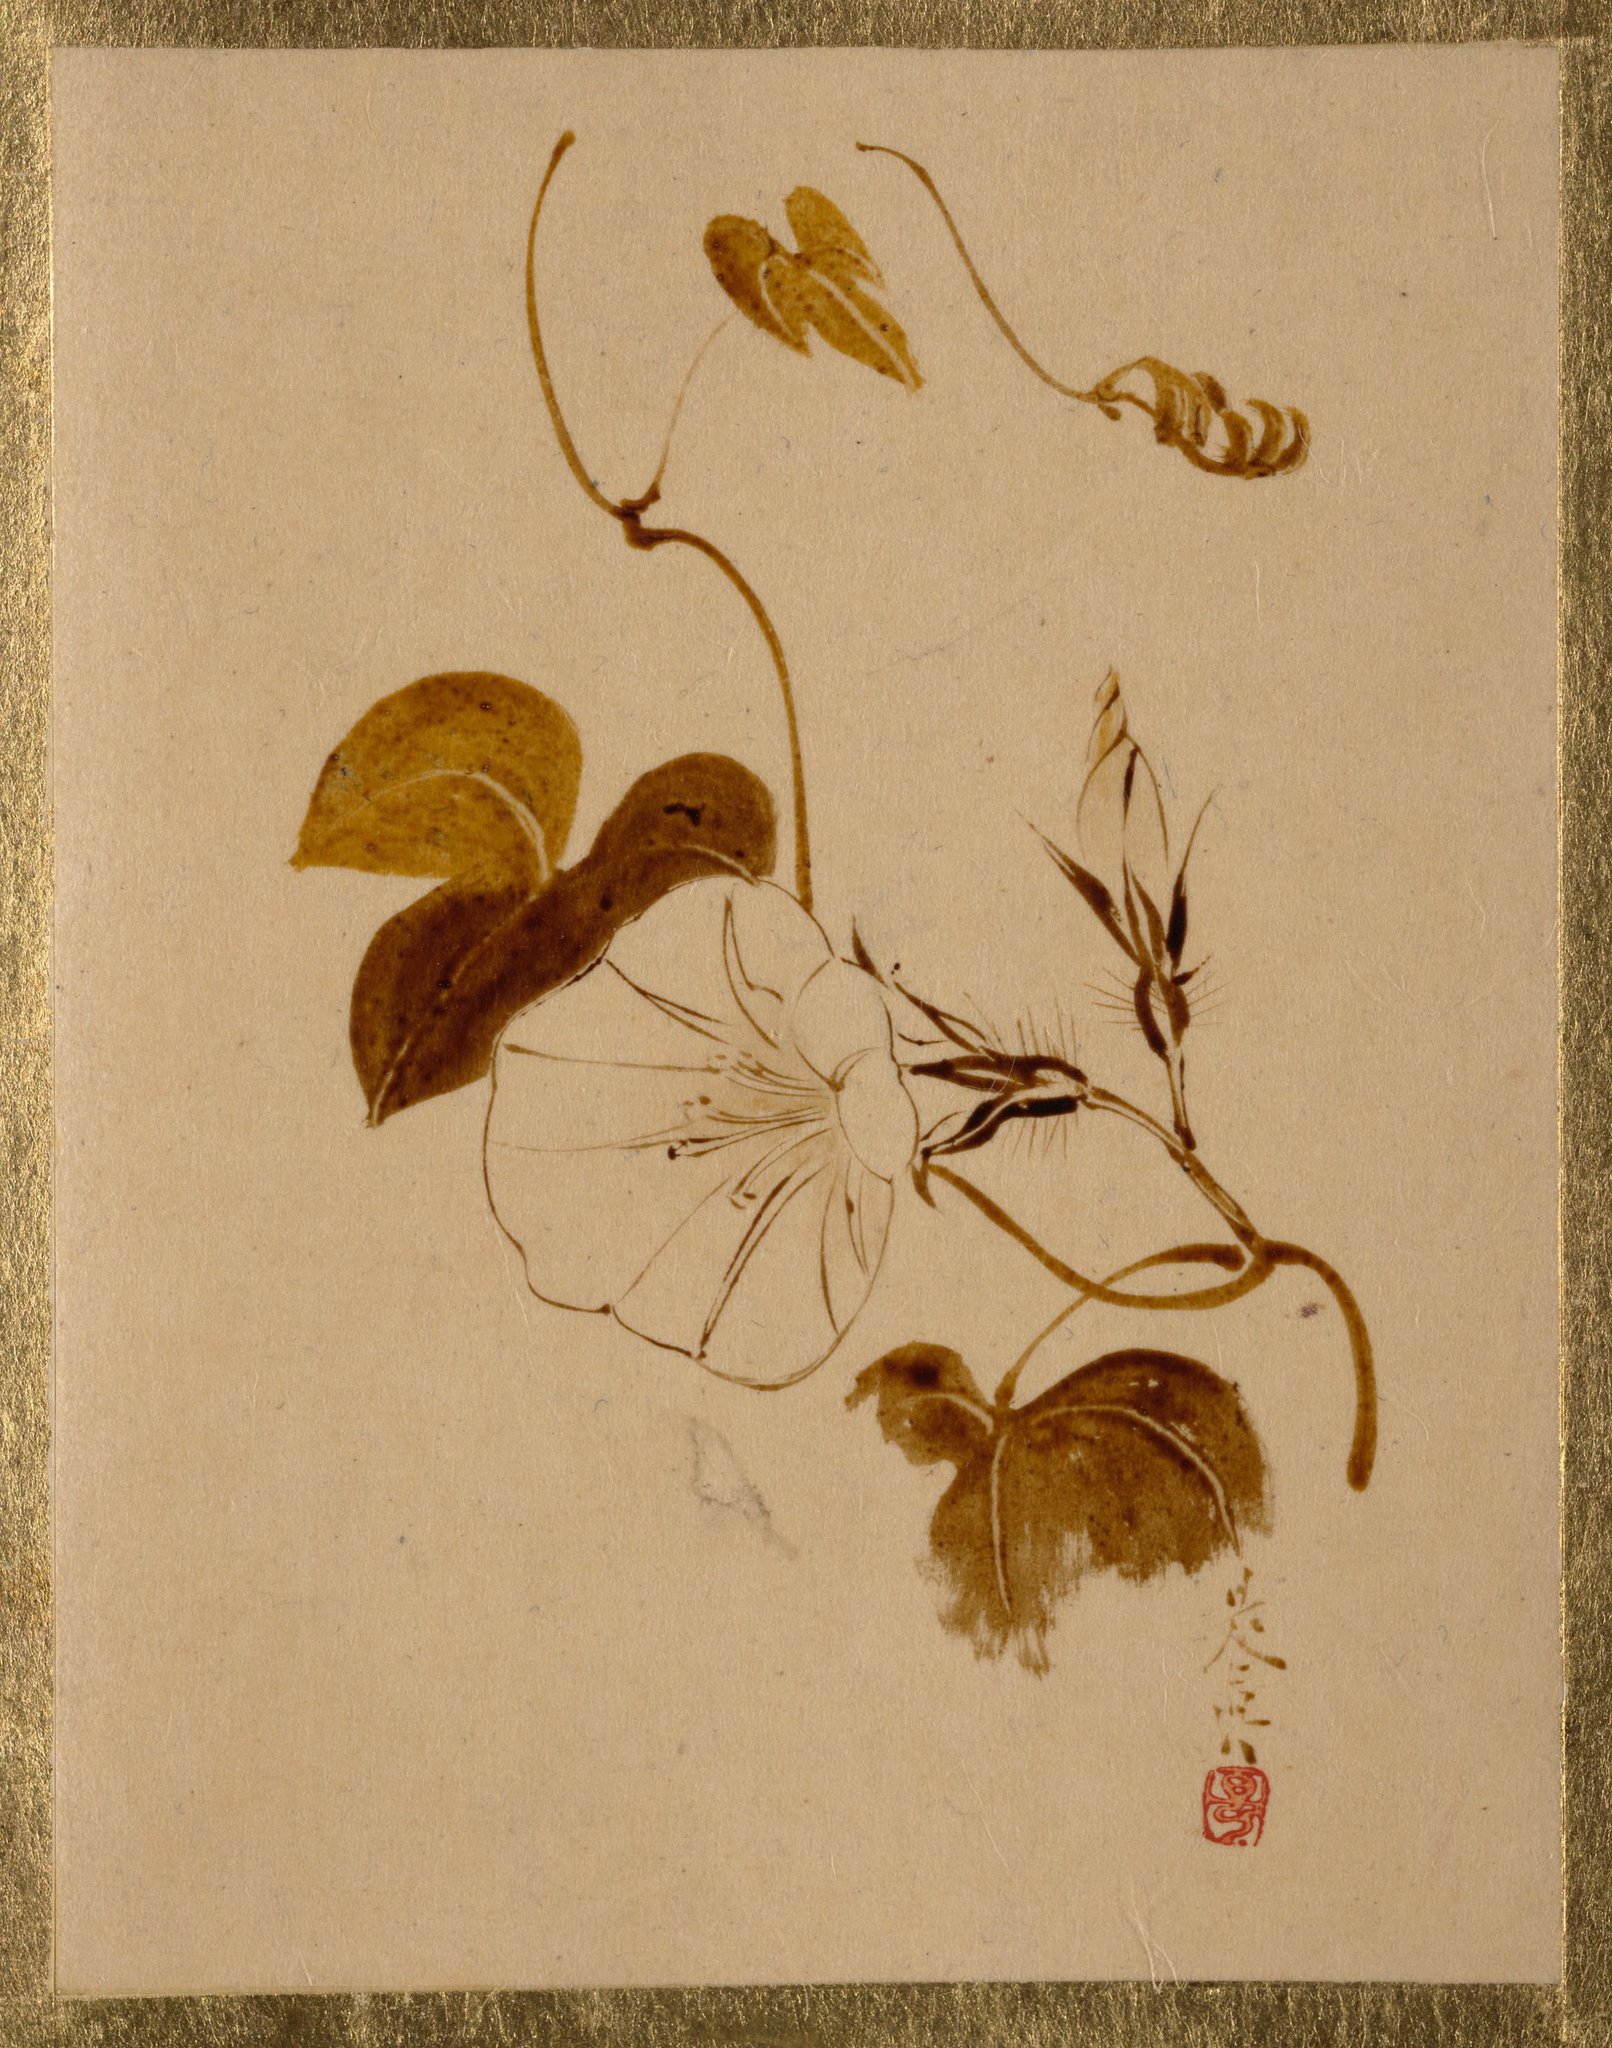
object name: album leaf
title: Morning Glory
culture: japanese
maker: shibata zeshin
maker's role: artist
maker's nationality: japanese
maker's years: 1807-1891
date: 1807-1868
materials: lacquer, paper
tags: flowers